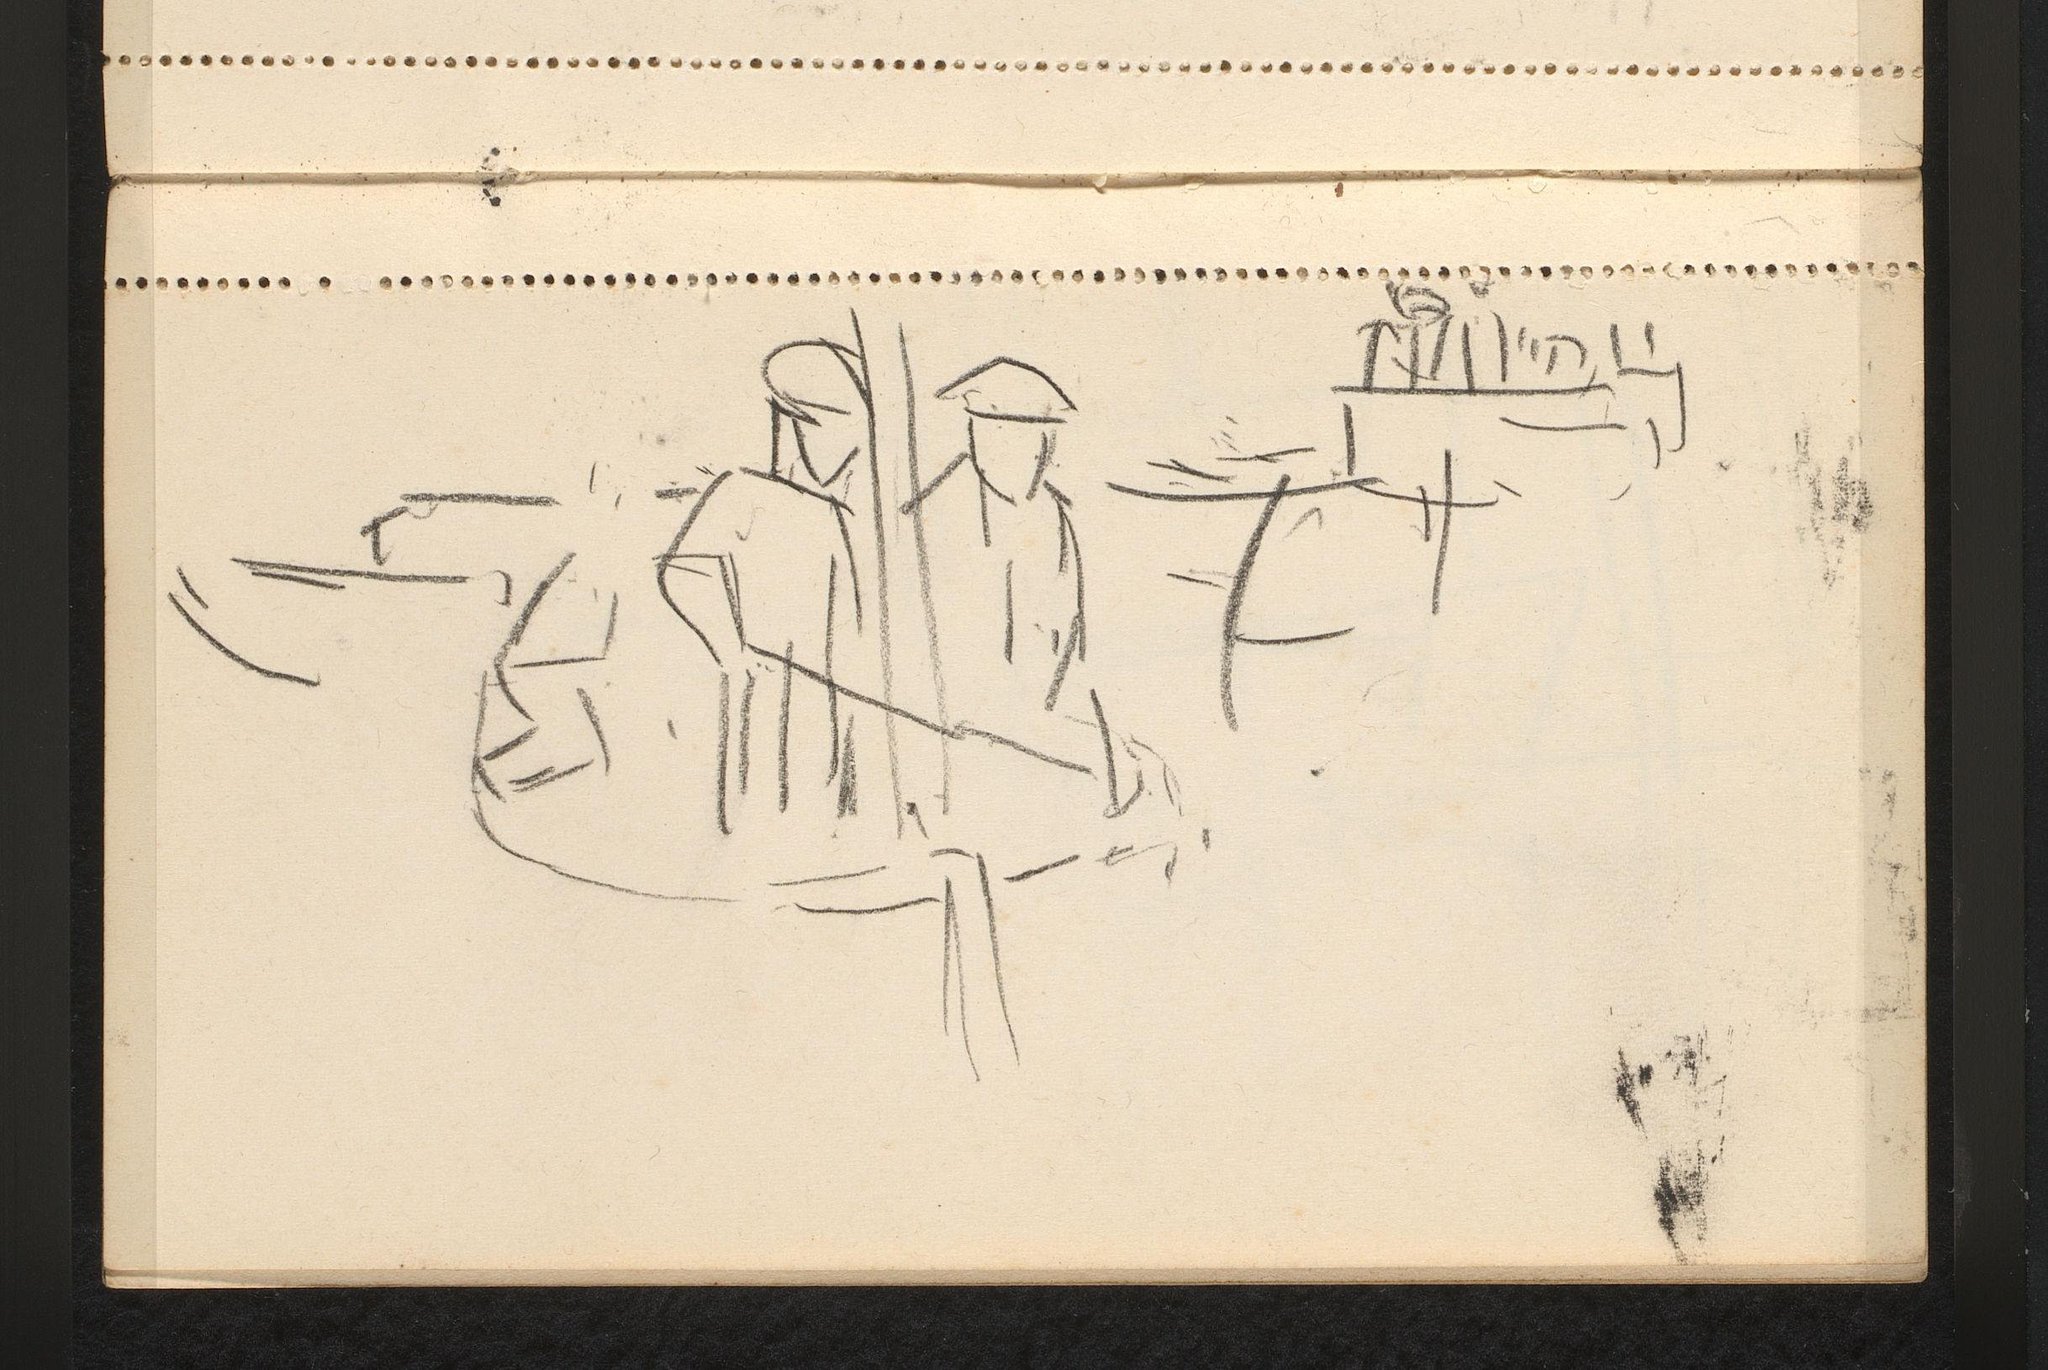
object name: sketchbook leaf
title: Twee vissers in een boot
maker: gerrit van blaaderen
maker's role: draughtsman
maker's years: 1873-1935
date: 1908-1927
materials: chalk, paper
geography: france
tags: sailing-ship, sailing-boat, fisherman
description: Blad 10 recto uit een schetsboek met 33 bladen.